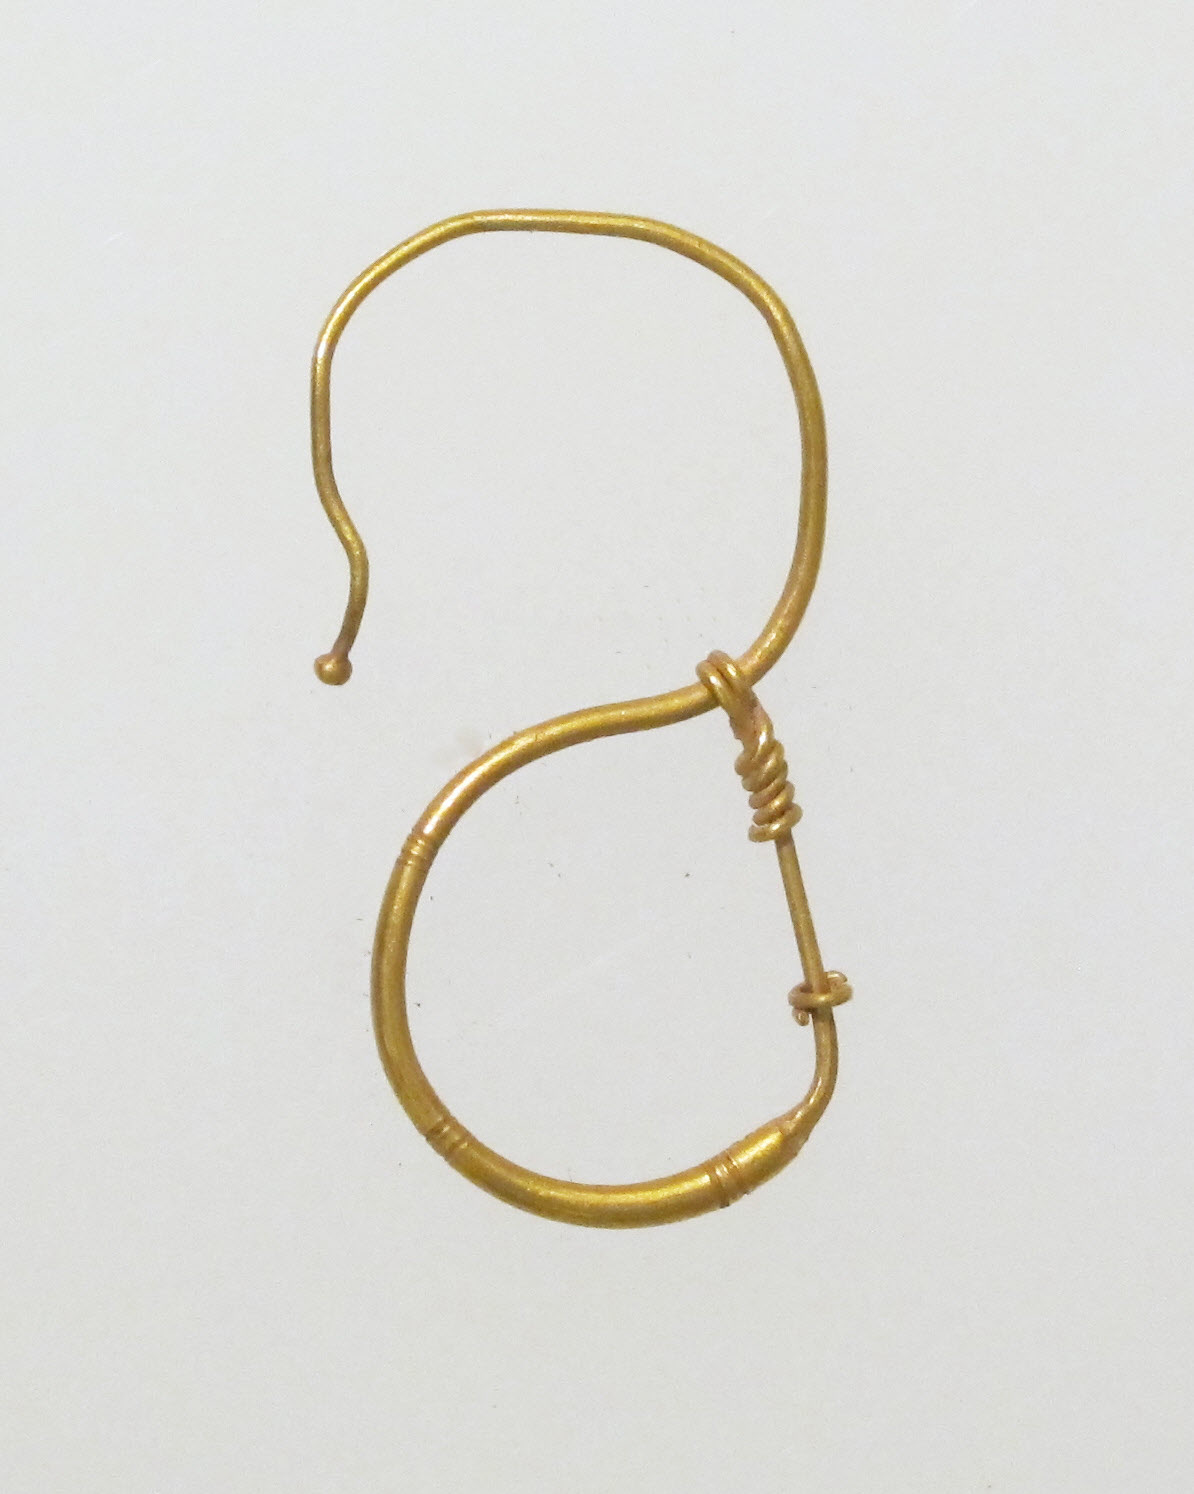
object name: earring, delta shaped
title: Earring, delta-shaped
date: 7000 BCE-330 CE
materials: gold